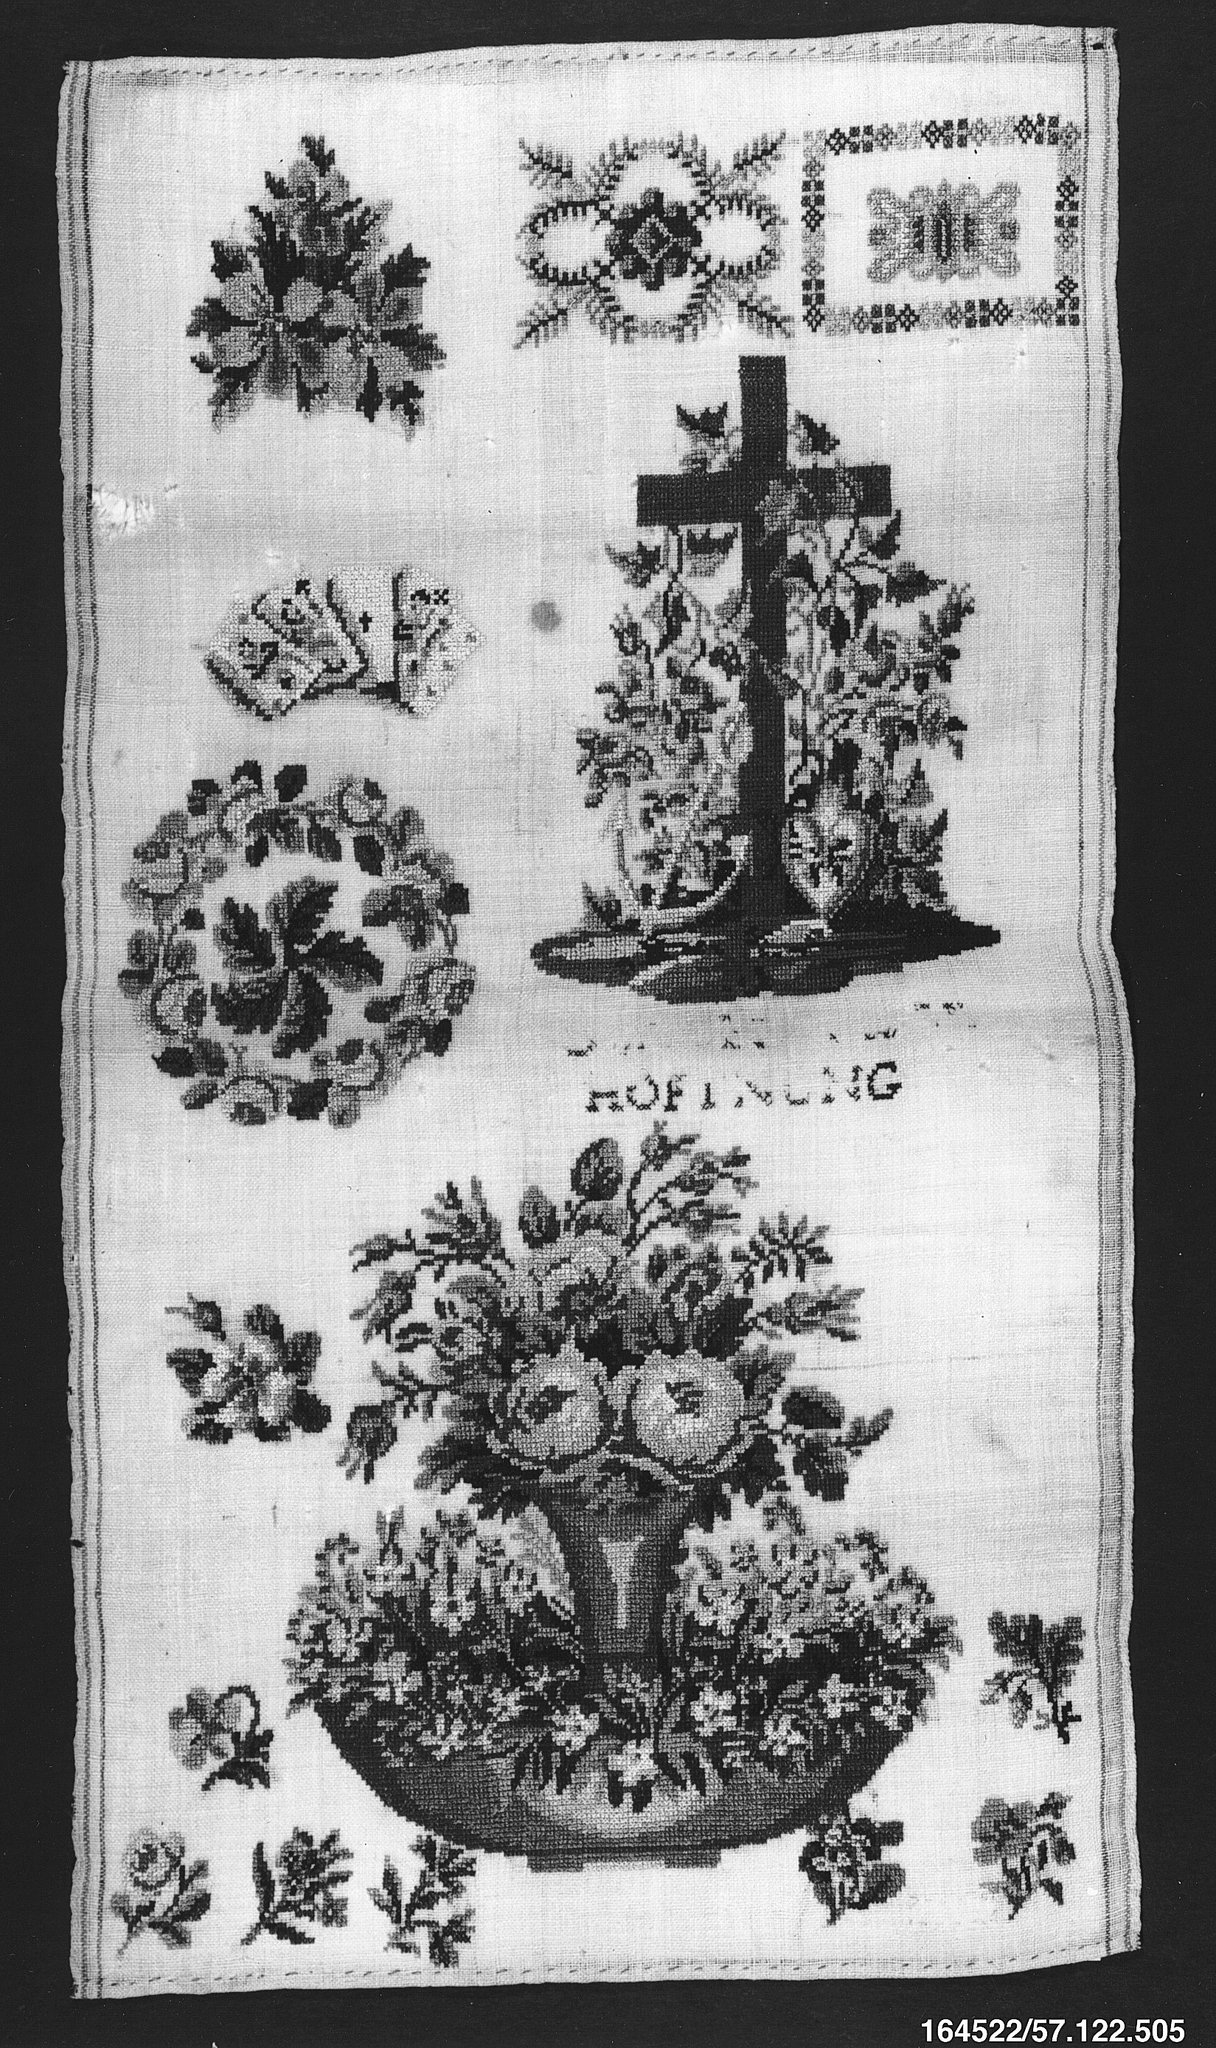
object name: sampler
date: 1801-1900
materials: canvas, silk, wool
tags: flowers,cross